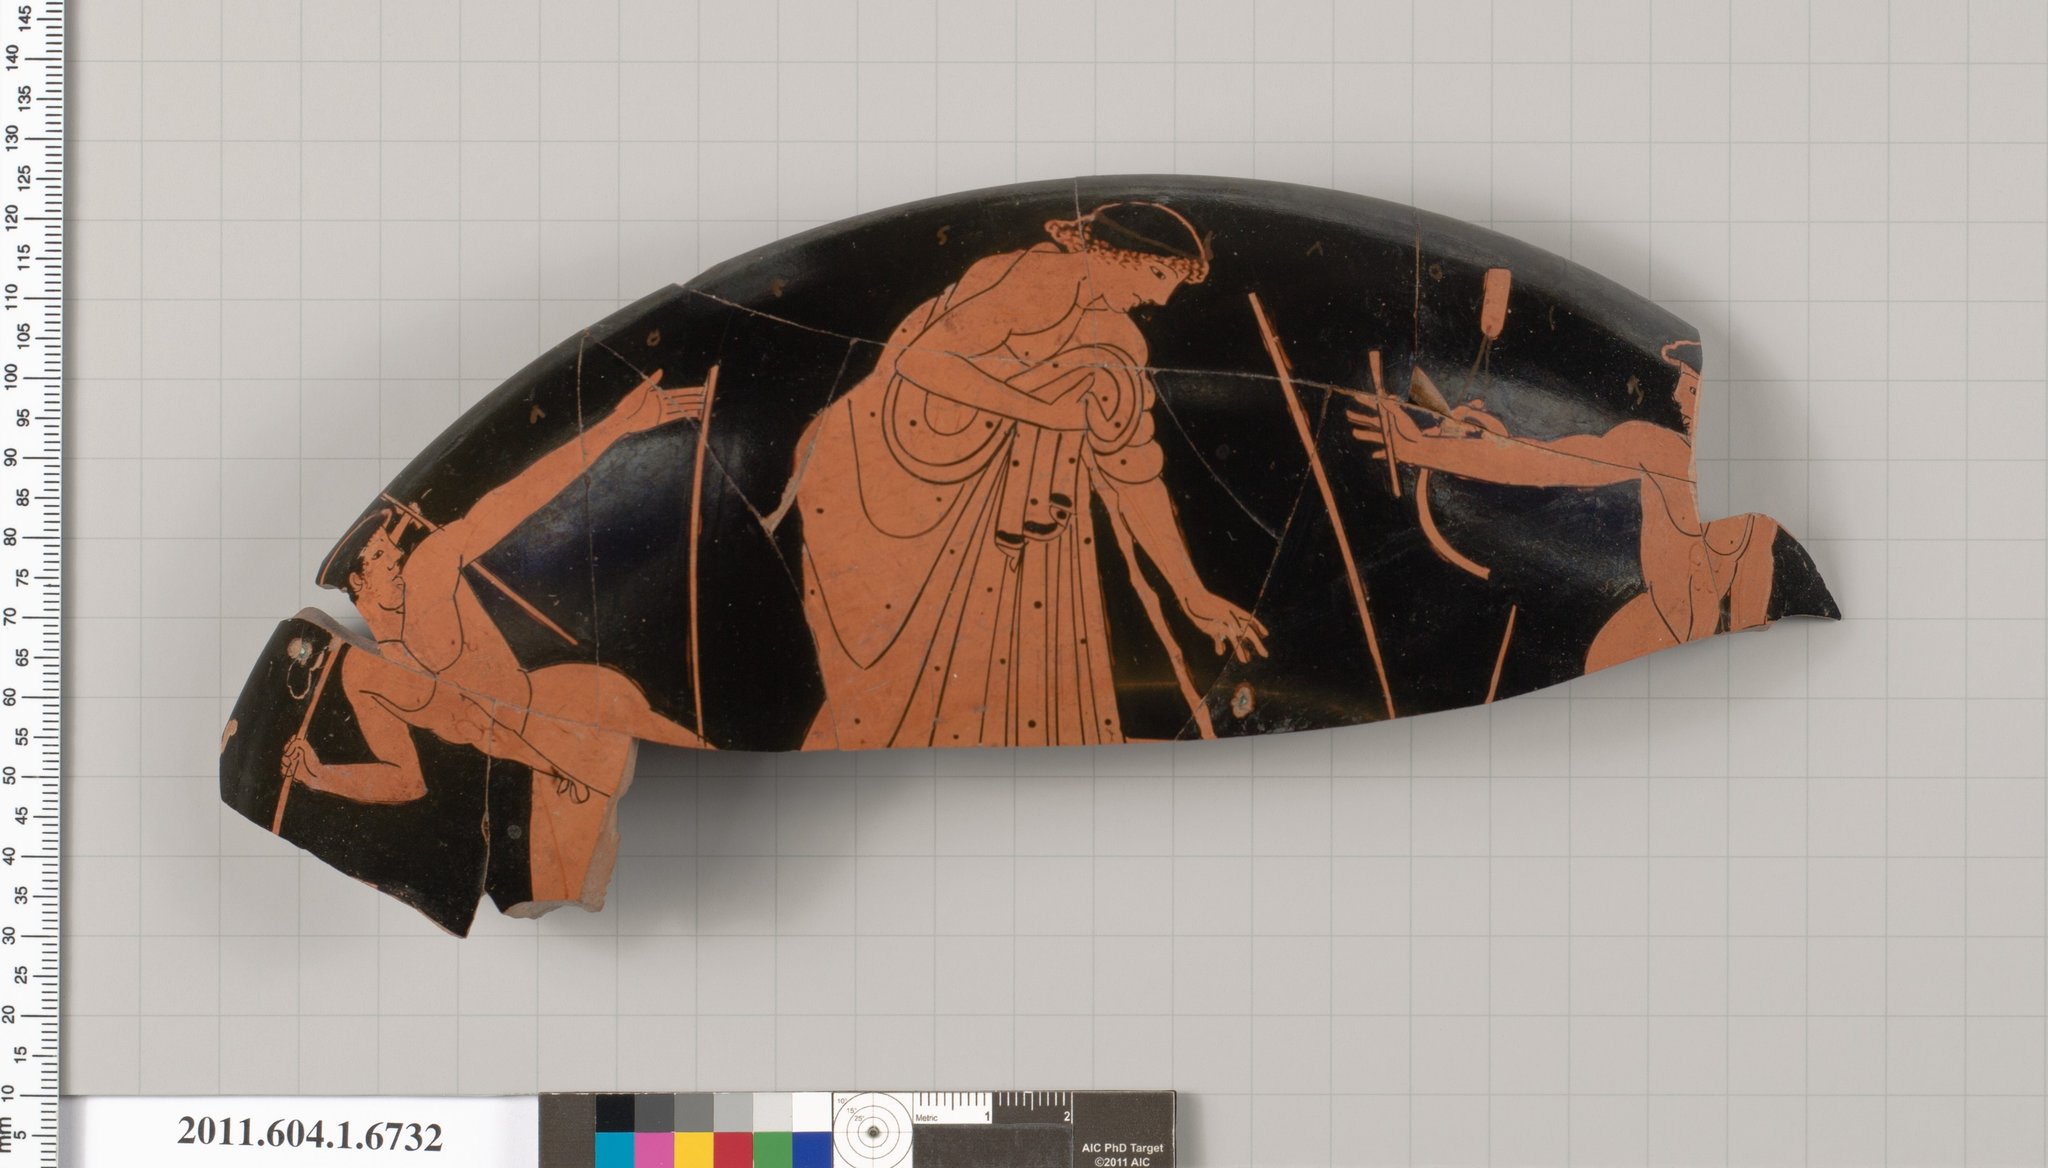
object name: kylix fragment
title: Terracotta rim fragment of a kylix (drinking cup)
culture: greek, attic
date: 490-470 BCE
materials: terracotta